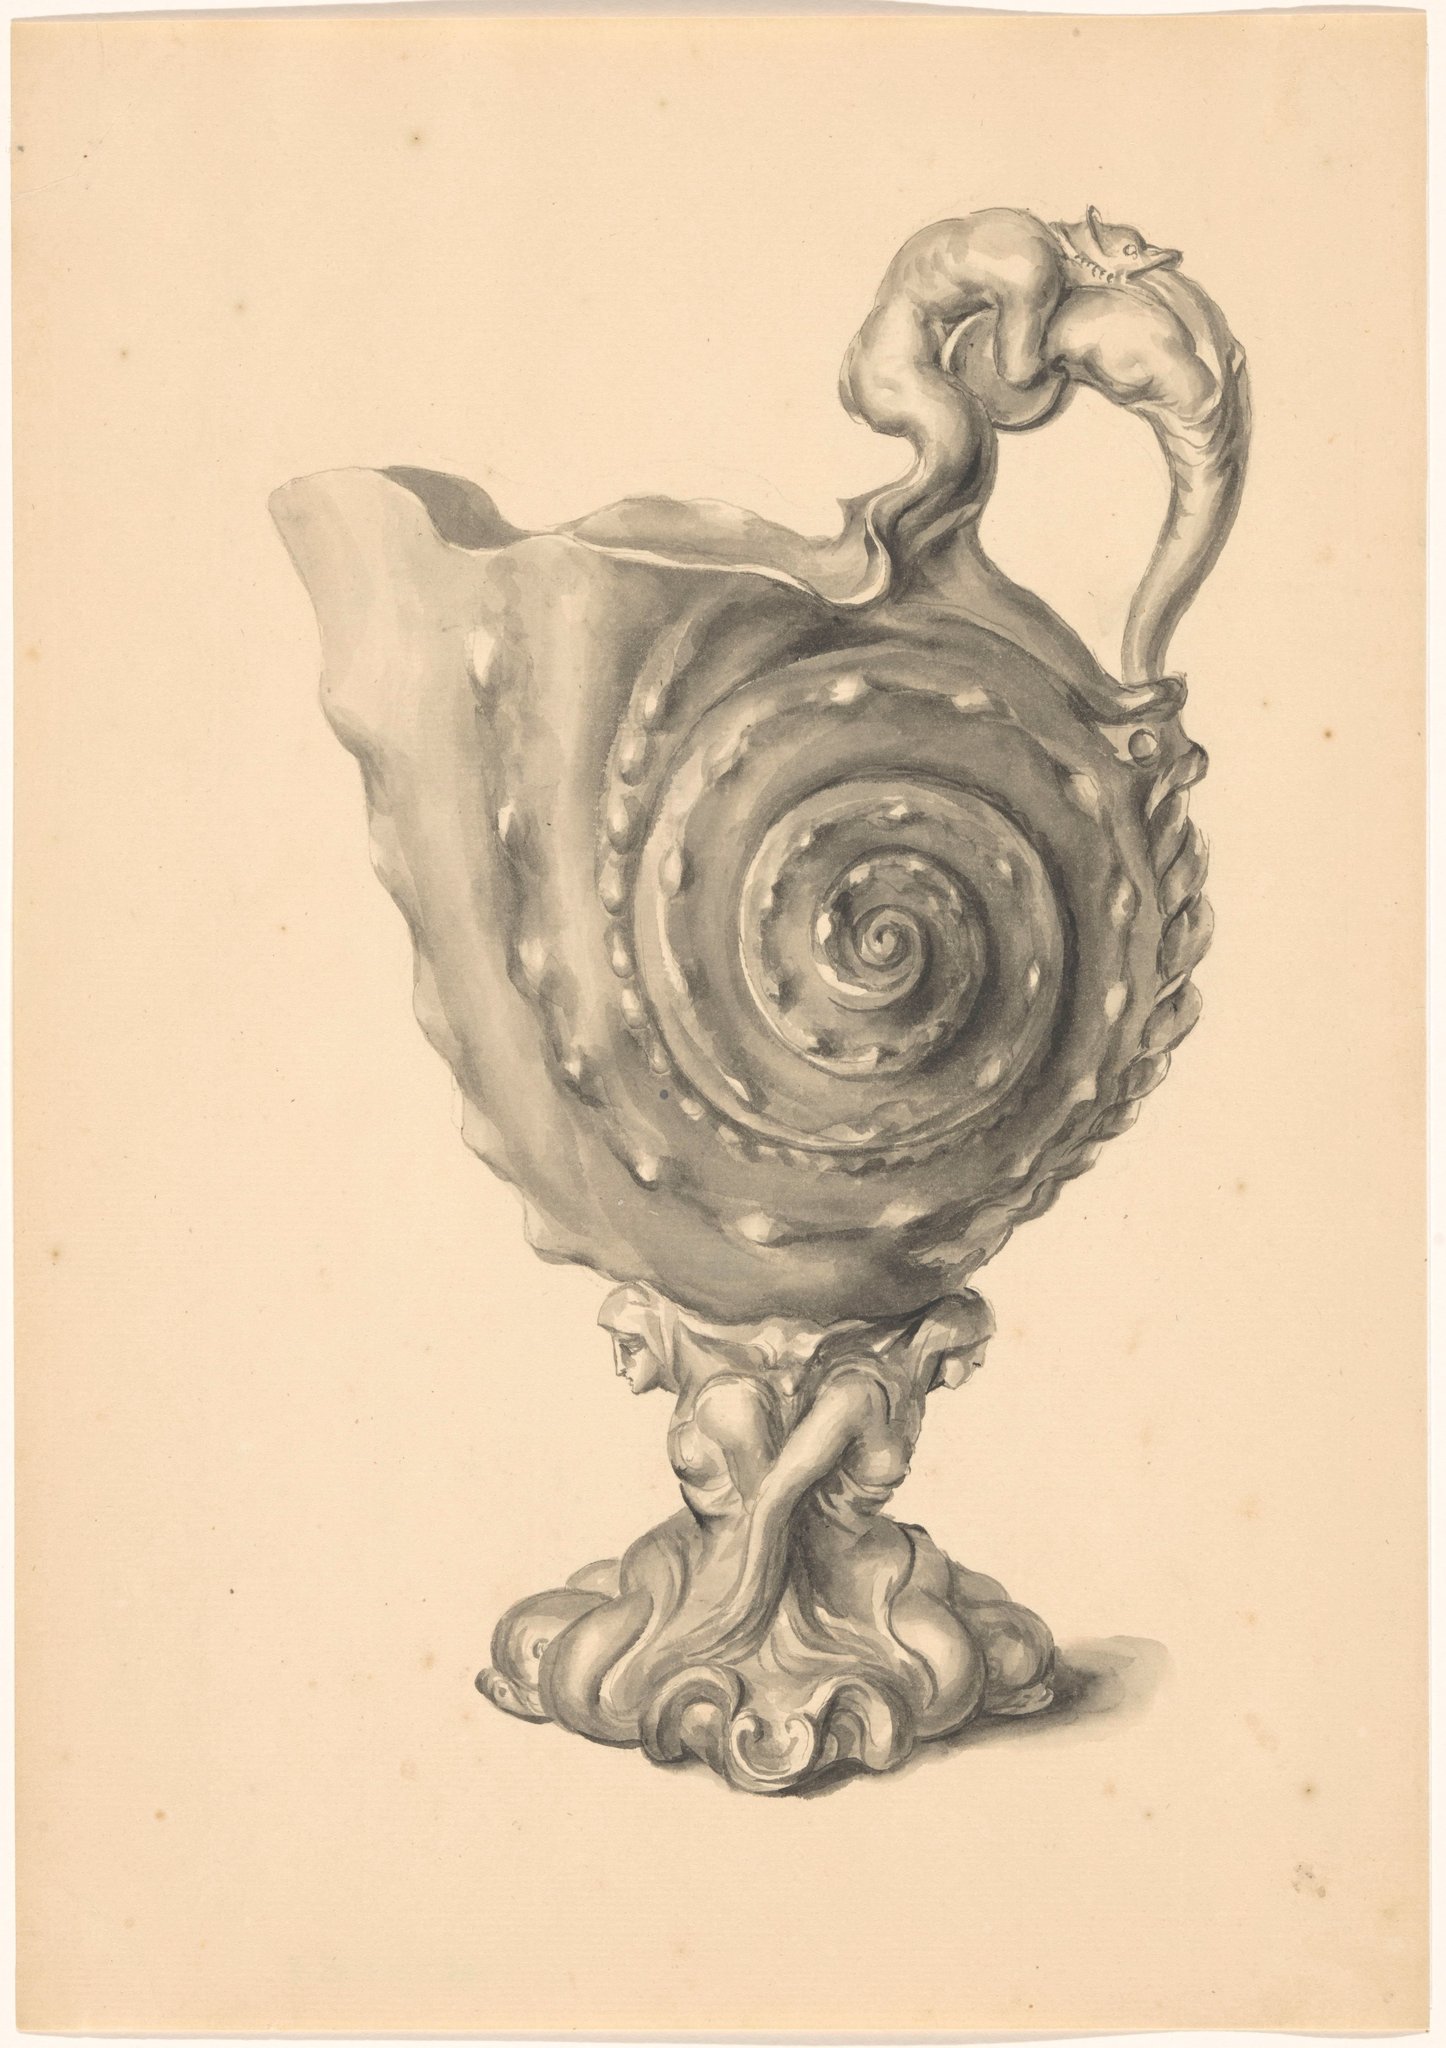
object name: album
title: Tekening van 17e eeuws zilver behorende bij een album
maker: Anonymous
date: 1725-1728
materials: paper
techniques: drawing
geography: amsterdam